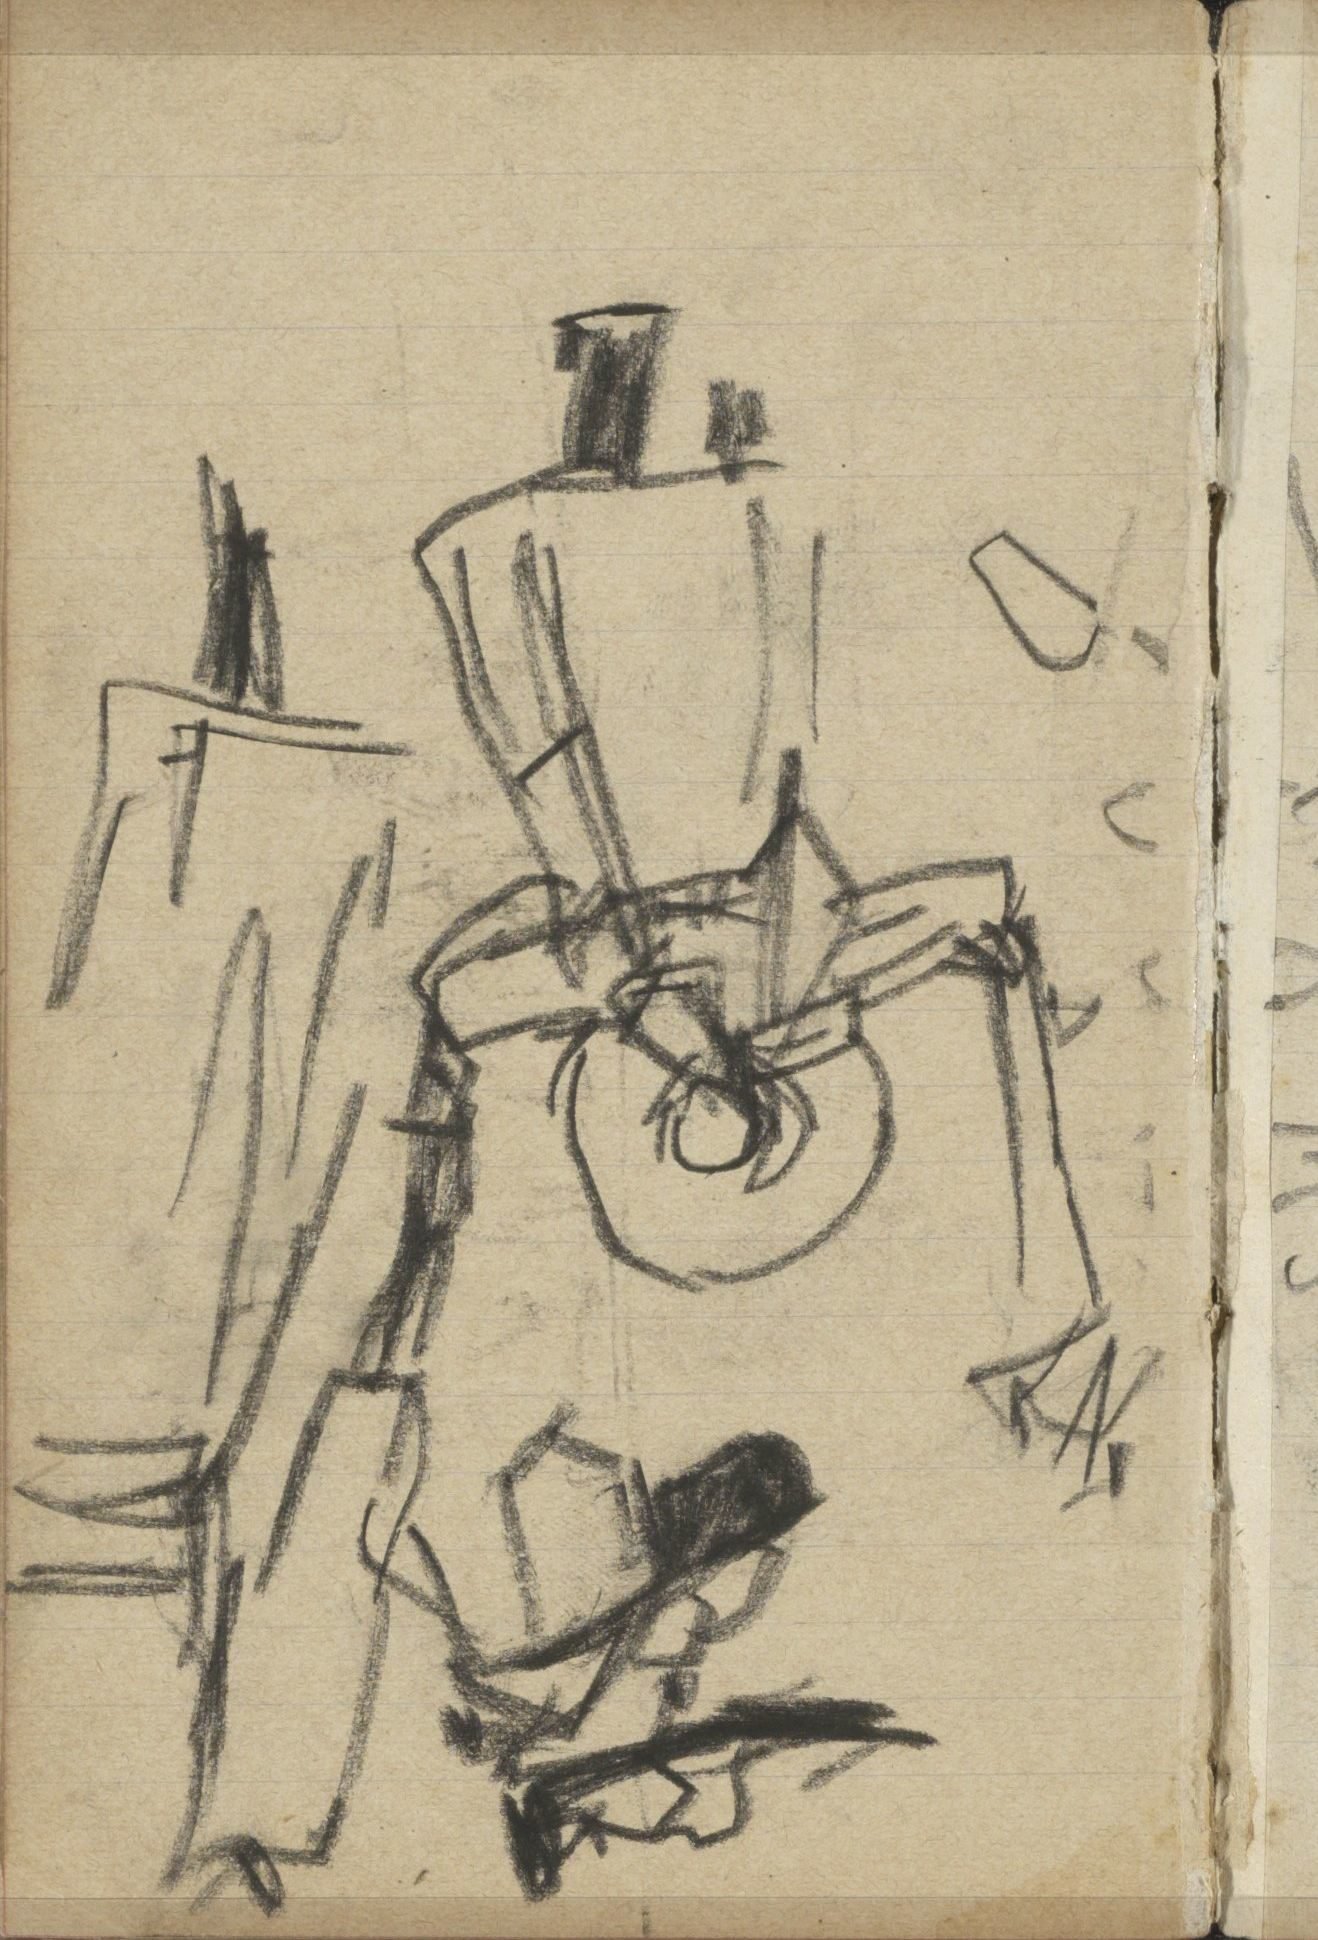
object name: sketchbook leaf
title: Vrouw met twee meisjes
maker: george hendrik breitner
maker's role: draughtsman, painter, print maker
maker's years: 1857-1923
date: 1886-1903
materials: chalk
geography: amsterdam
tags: adult woman, girl (child between toddler and youth), mother and child(ren), woman and child(ren) (family group)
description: Op de achtergrond nog een vrouw. Pagina 57 uit een schetsboek met 41 bladen.